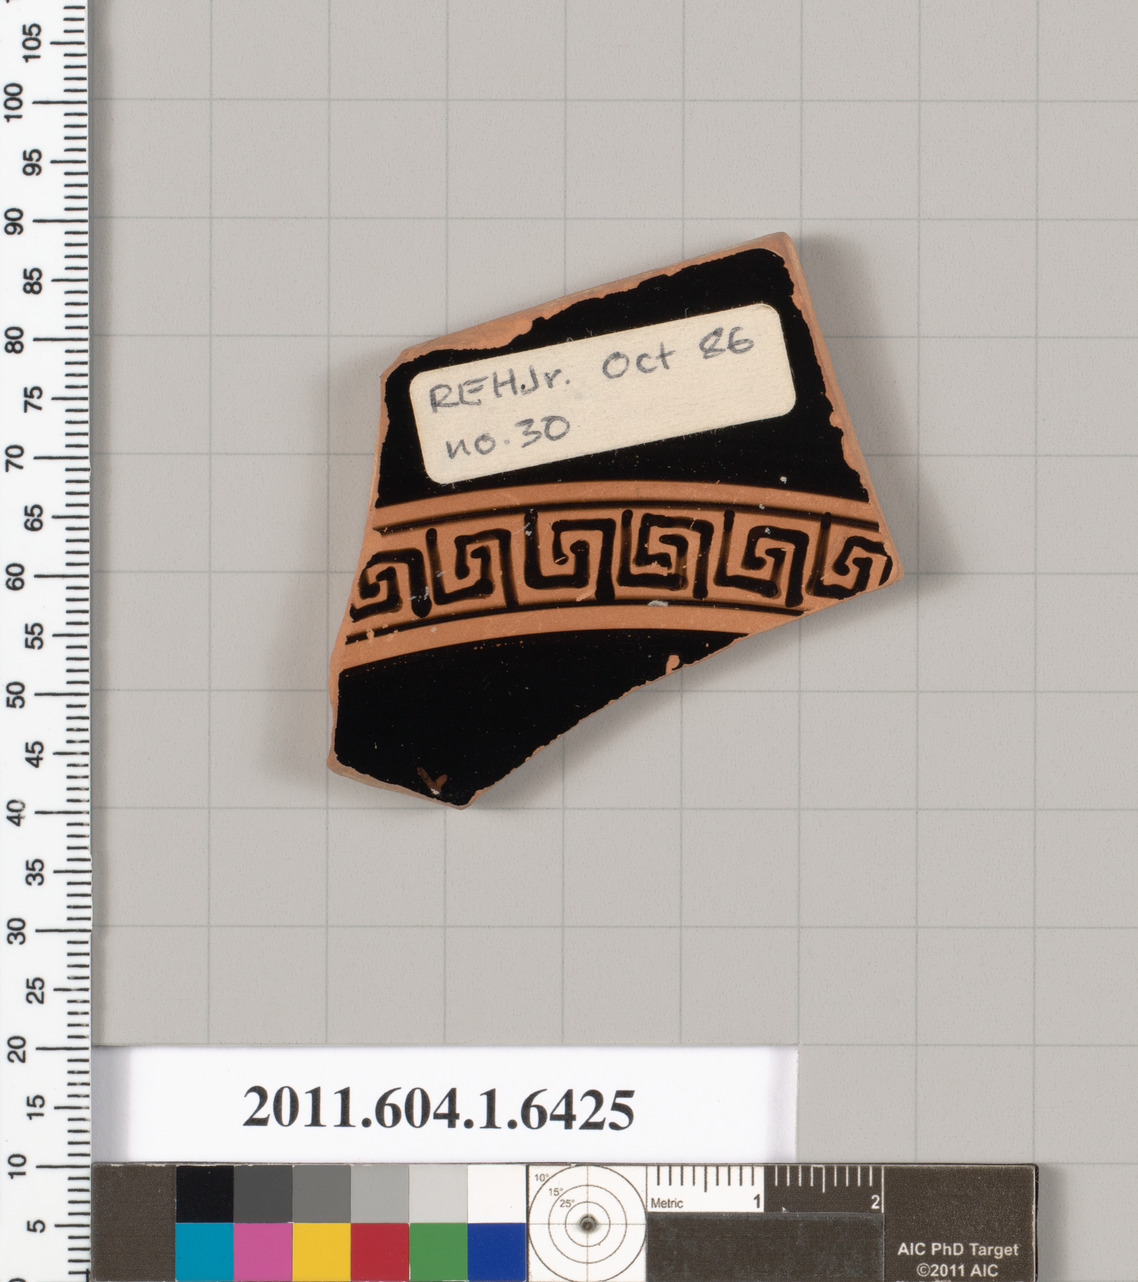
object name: kylix fragment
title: Terracotta fragment of a kylix (drinking cup)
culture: greek, attic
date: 490-480 BCE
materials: terracotta